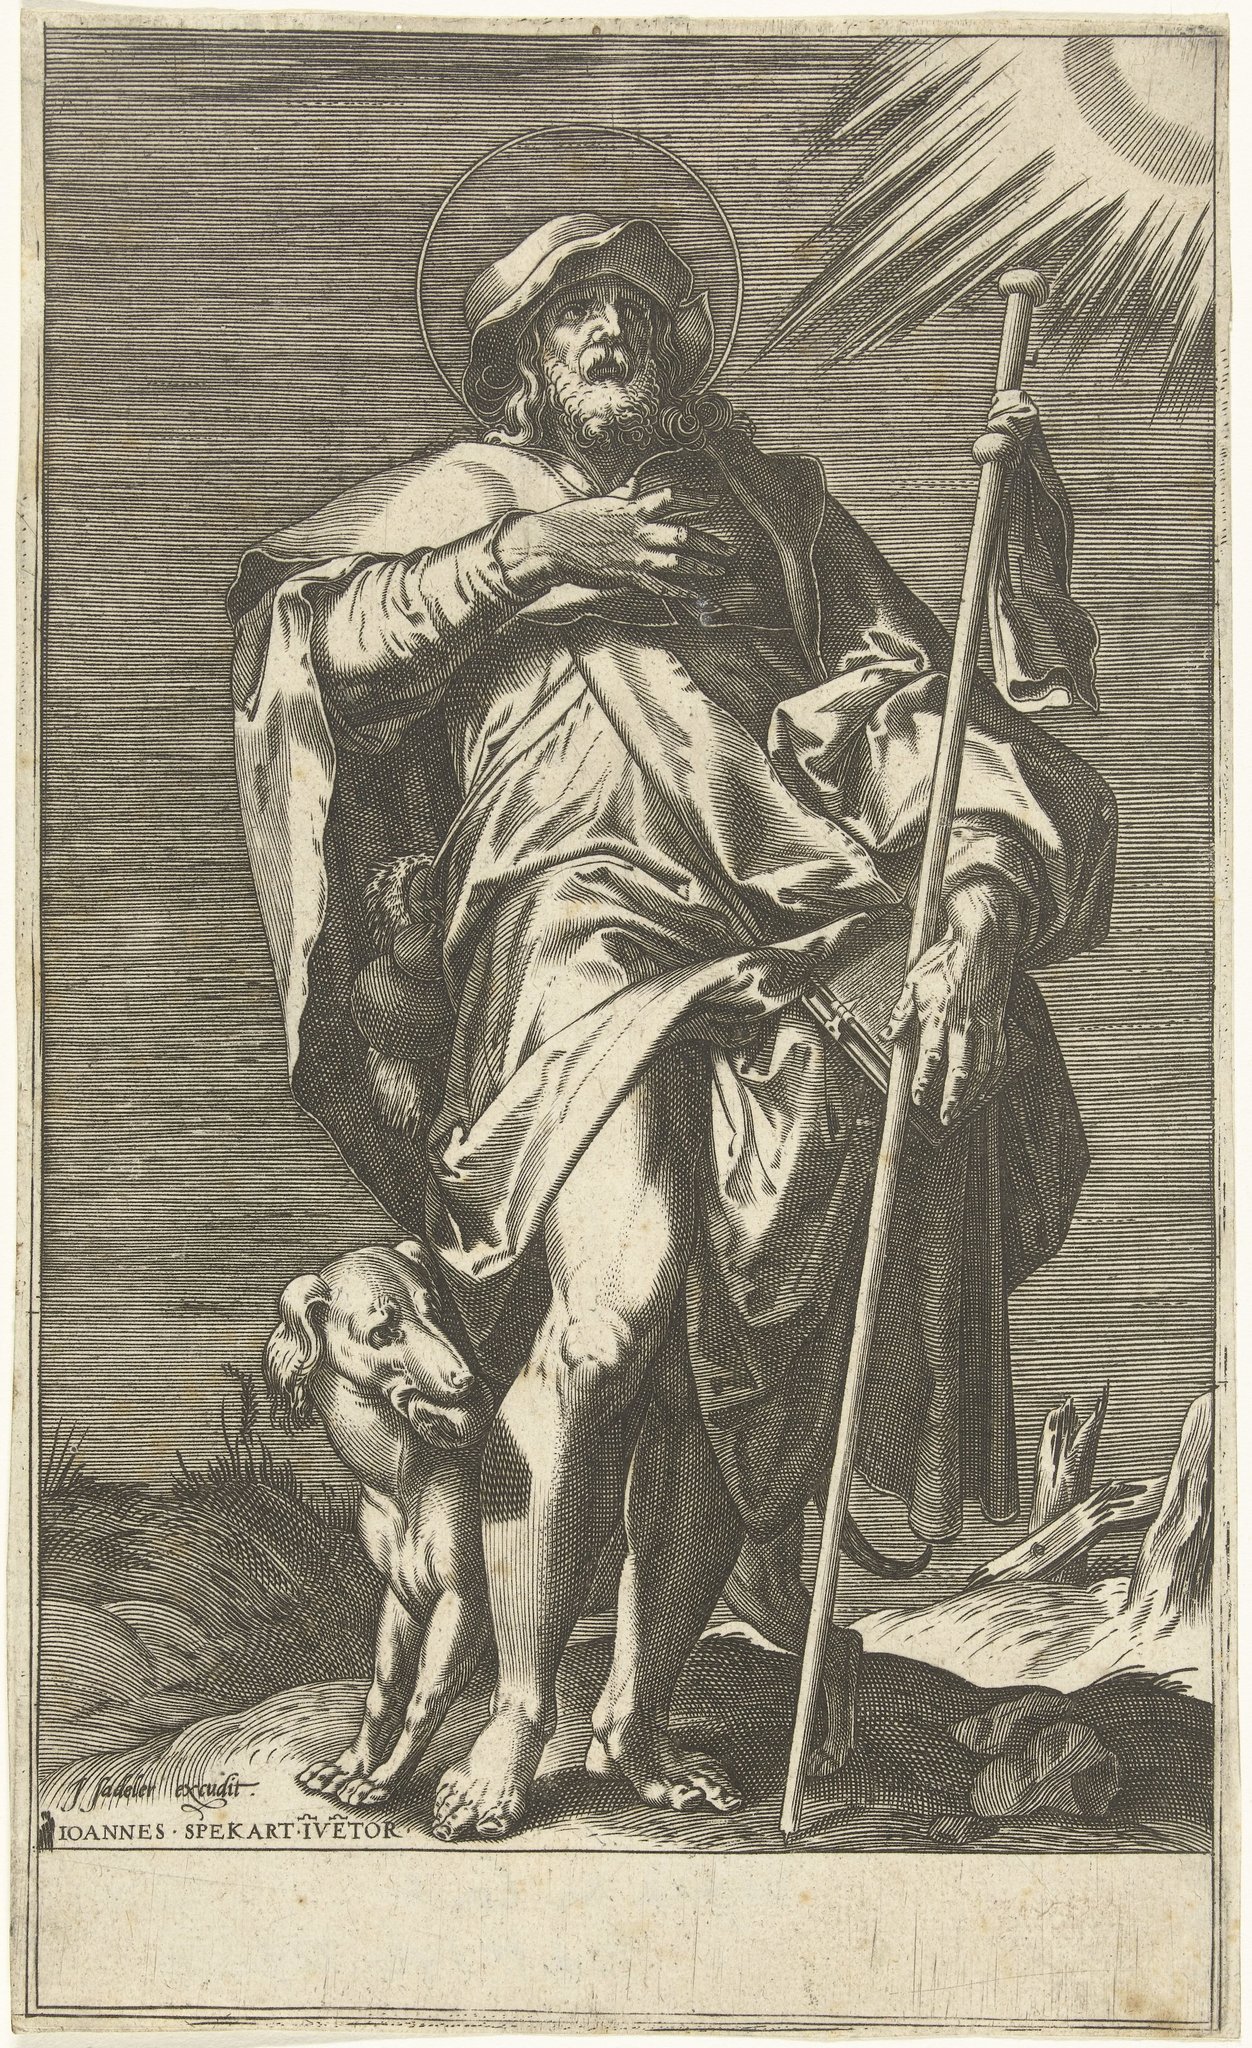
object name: print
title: De H. Rochus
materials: paper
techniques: engraving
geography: rome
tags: the confessor and pilgrim roch(us) (rocco, rock) of montpellier; possible attributes: angel (with ointment box or spoon), dog (sometimes with loaf), (pointing at) plague-spot on thigh, pilgrim's shell, staff, hat and wallet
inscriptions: collector's mark: Lugt 240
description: De heilige Rochus staand met een pelgrimsstaf. Achter zijn benen schuilt een hond met een appel in zijn bek. De hond bracht Rochus dagelijks vers eten toen hij aan de pest leed.